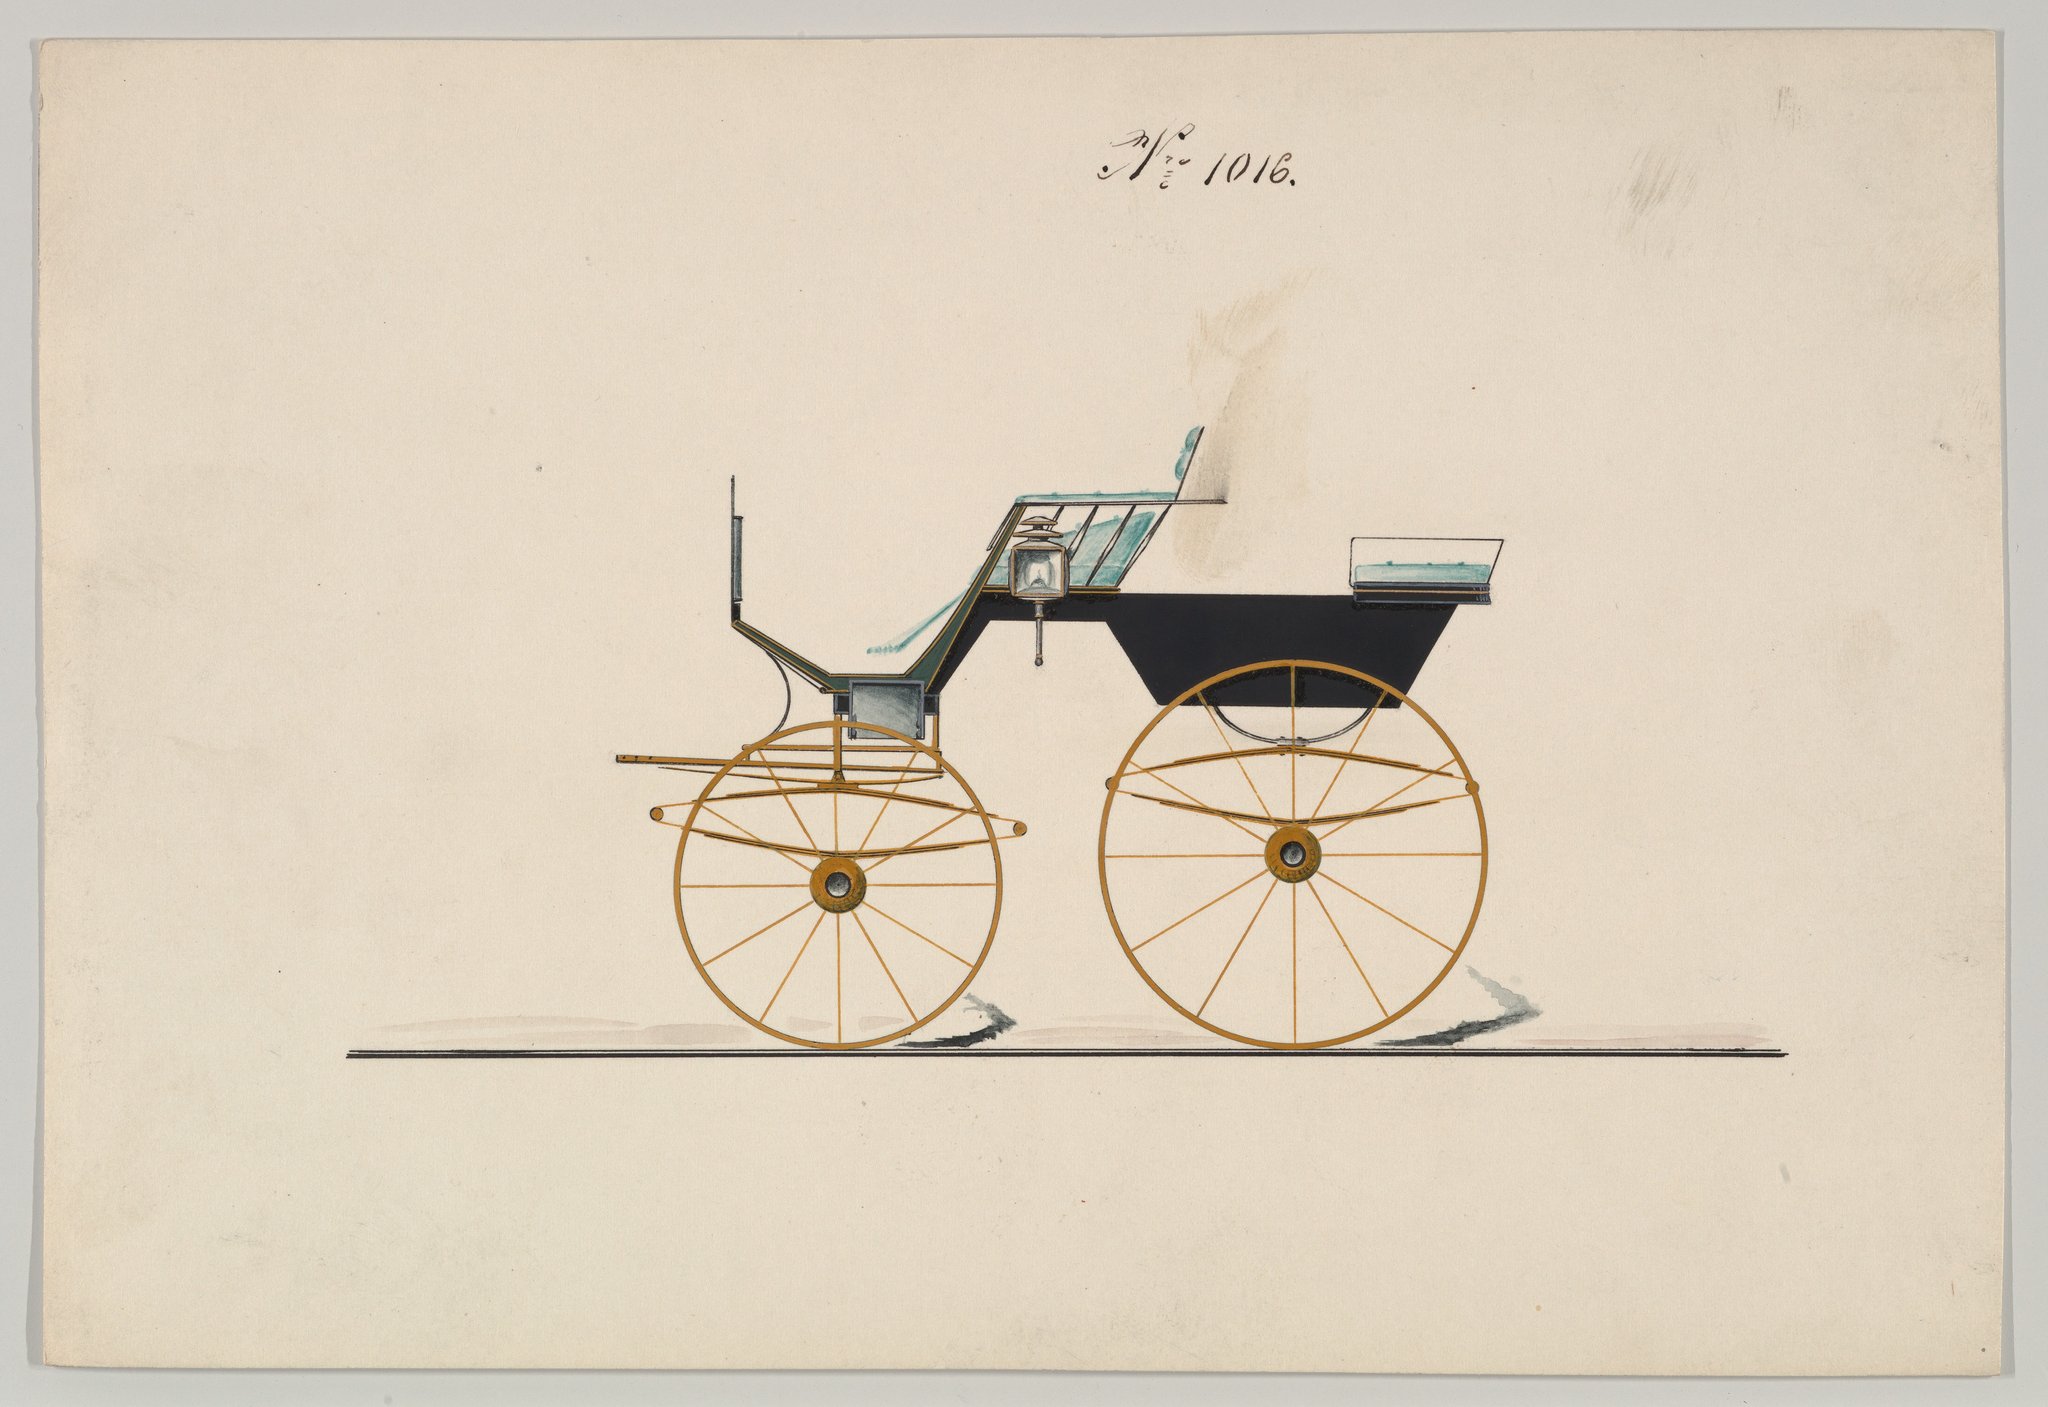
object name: drawing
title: T-Cart Phaeton #1016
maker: brewster & co.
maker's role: manufacturer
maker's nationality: american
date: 1850-1870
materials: gum arabic, watercolor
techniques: pen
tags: carriages